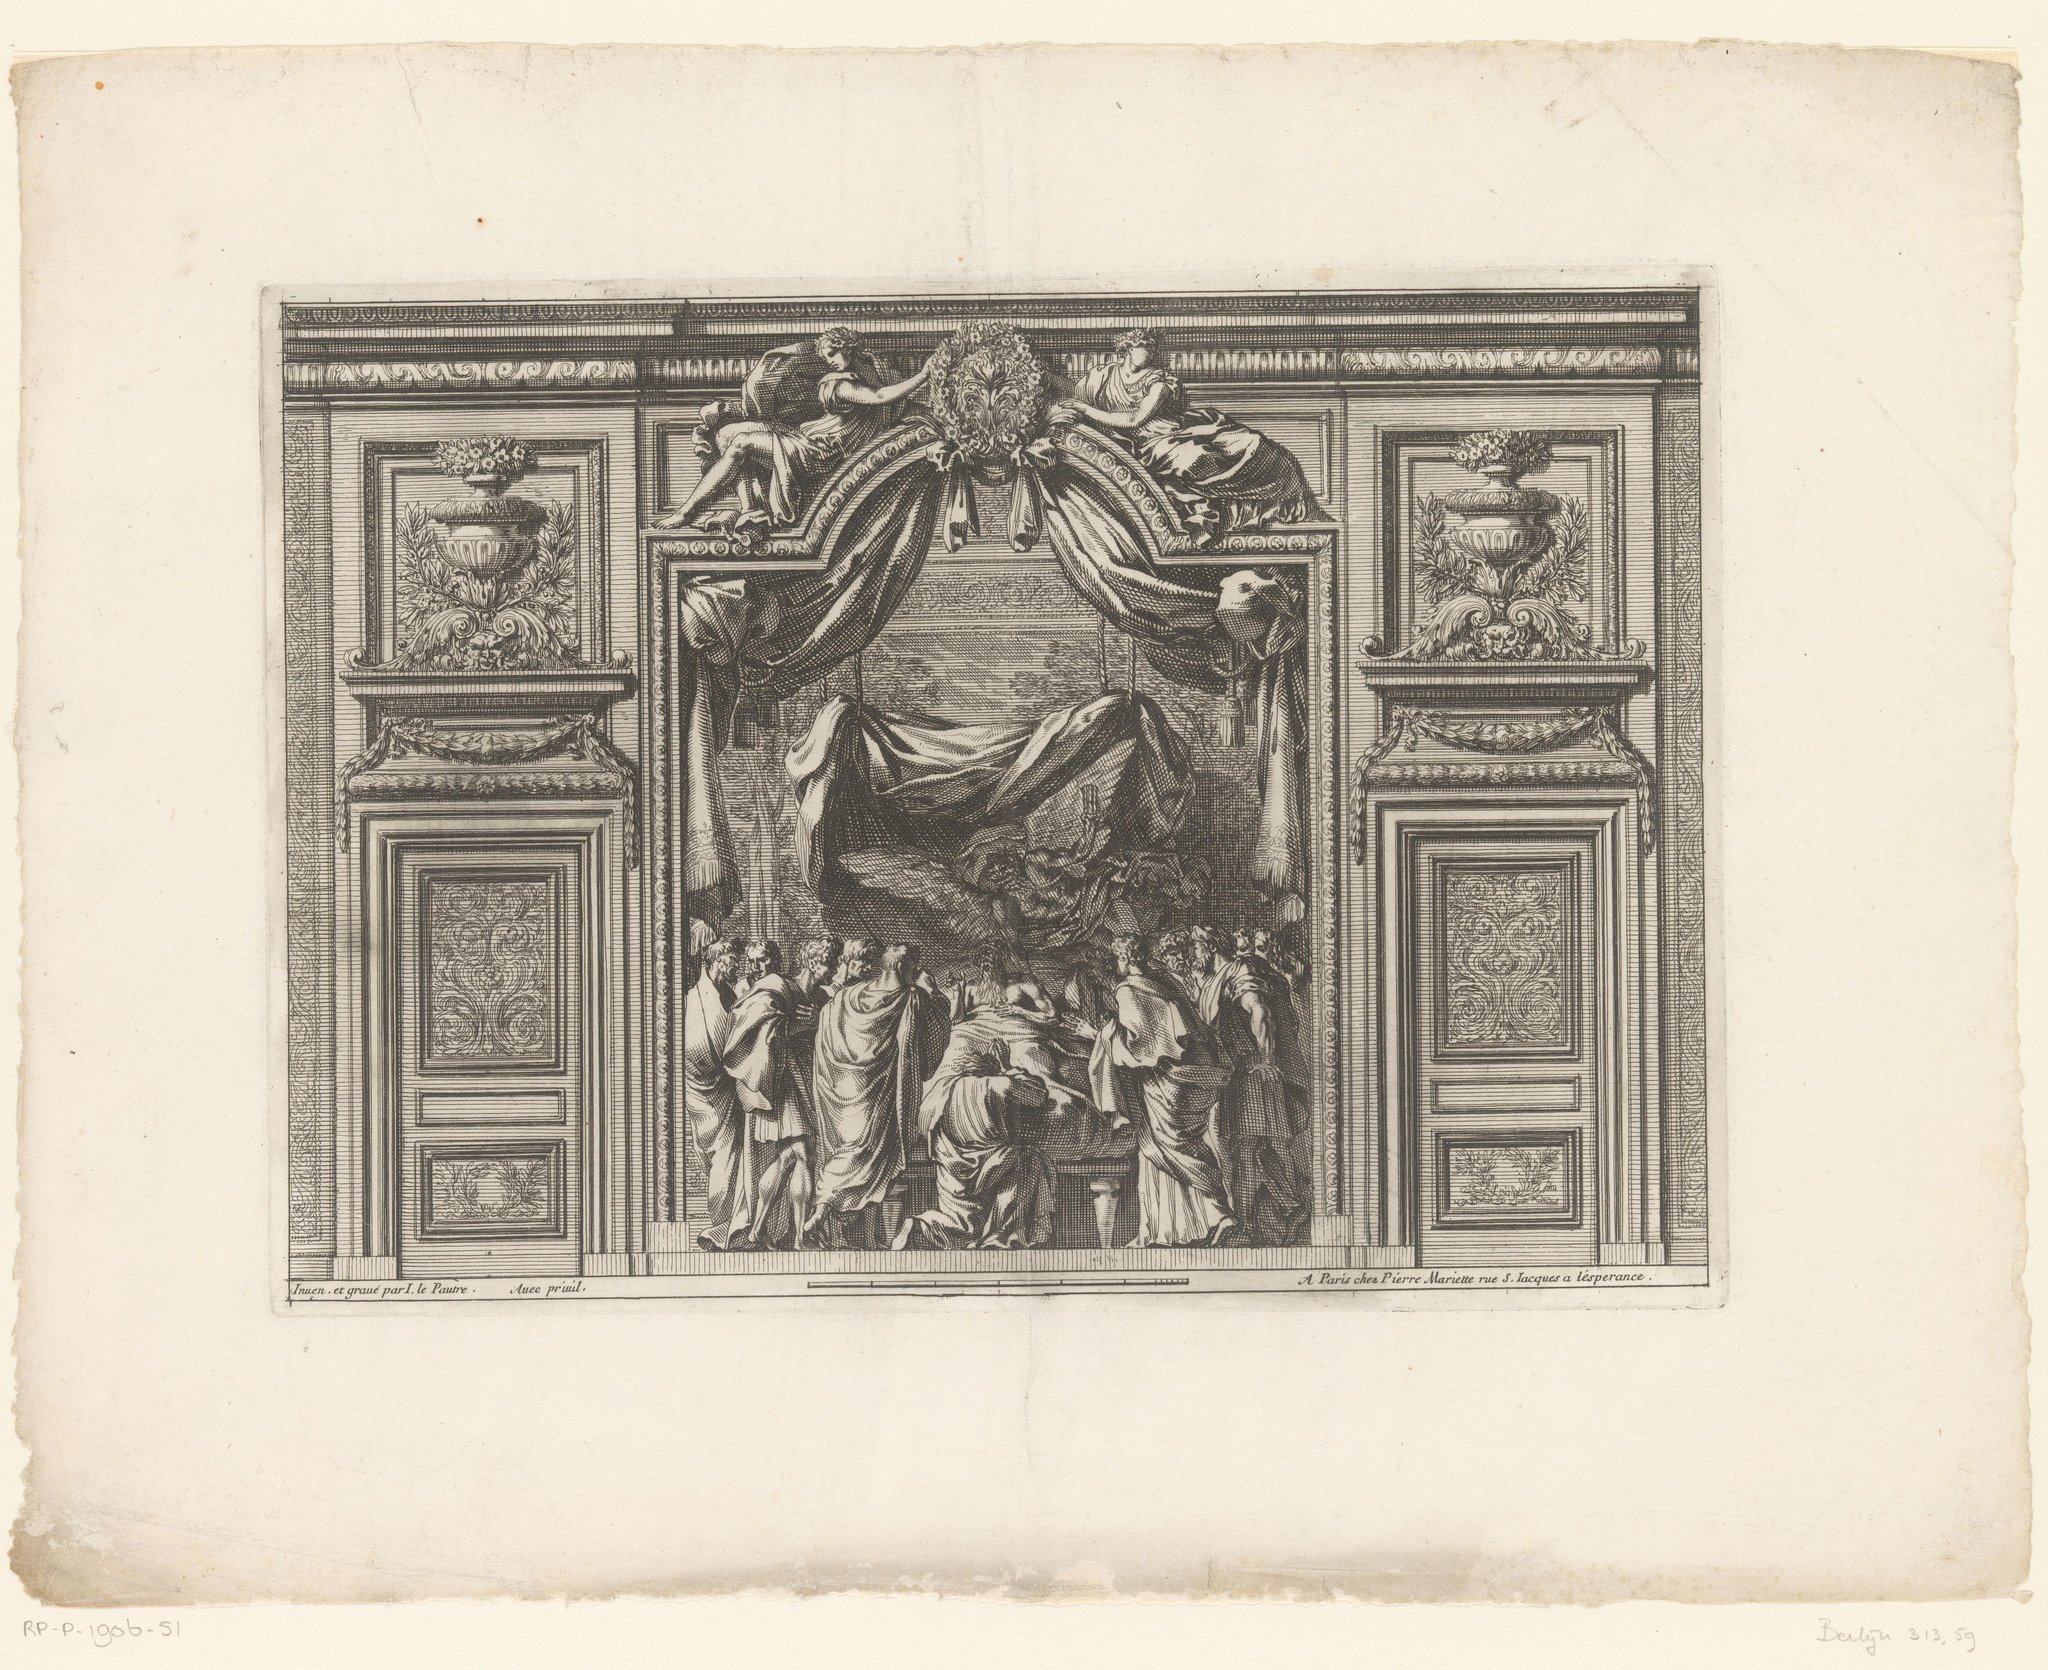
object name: ornament print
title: Dood van Jakob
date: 1667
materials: paper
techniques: etching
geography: paris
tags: jacob's death (genesis 49:33, 50:1-14)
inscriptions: collector's mark: Lugt 2228, inscription: ‘15a / 20-10-'81’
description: Jakob ligt op bed en wordt omringd door zijn twaalf zonen. Zijn zoon Jozef knielt voor het bed en ontvangt de zegen van zijn vader.